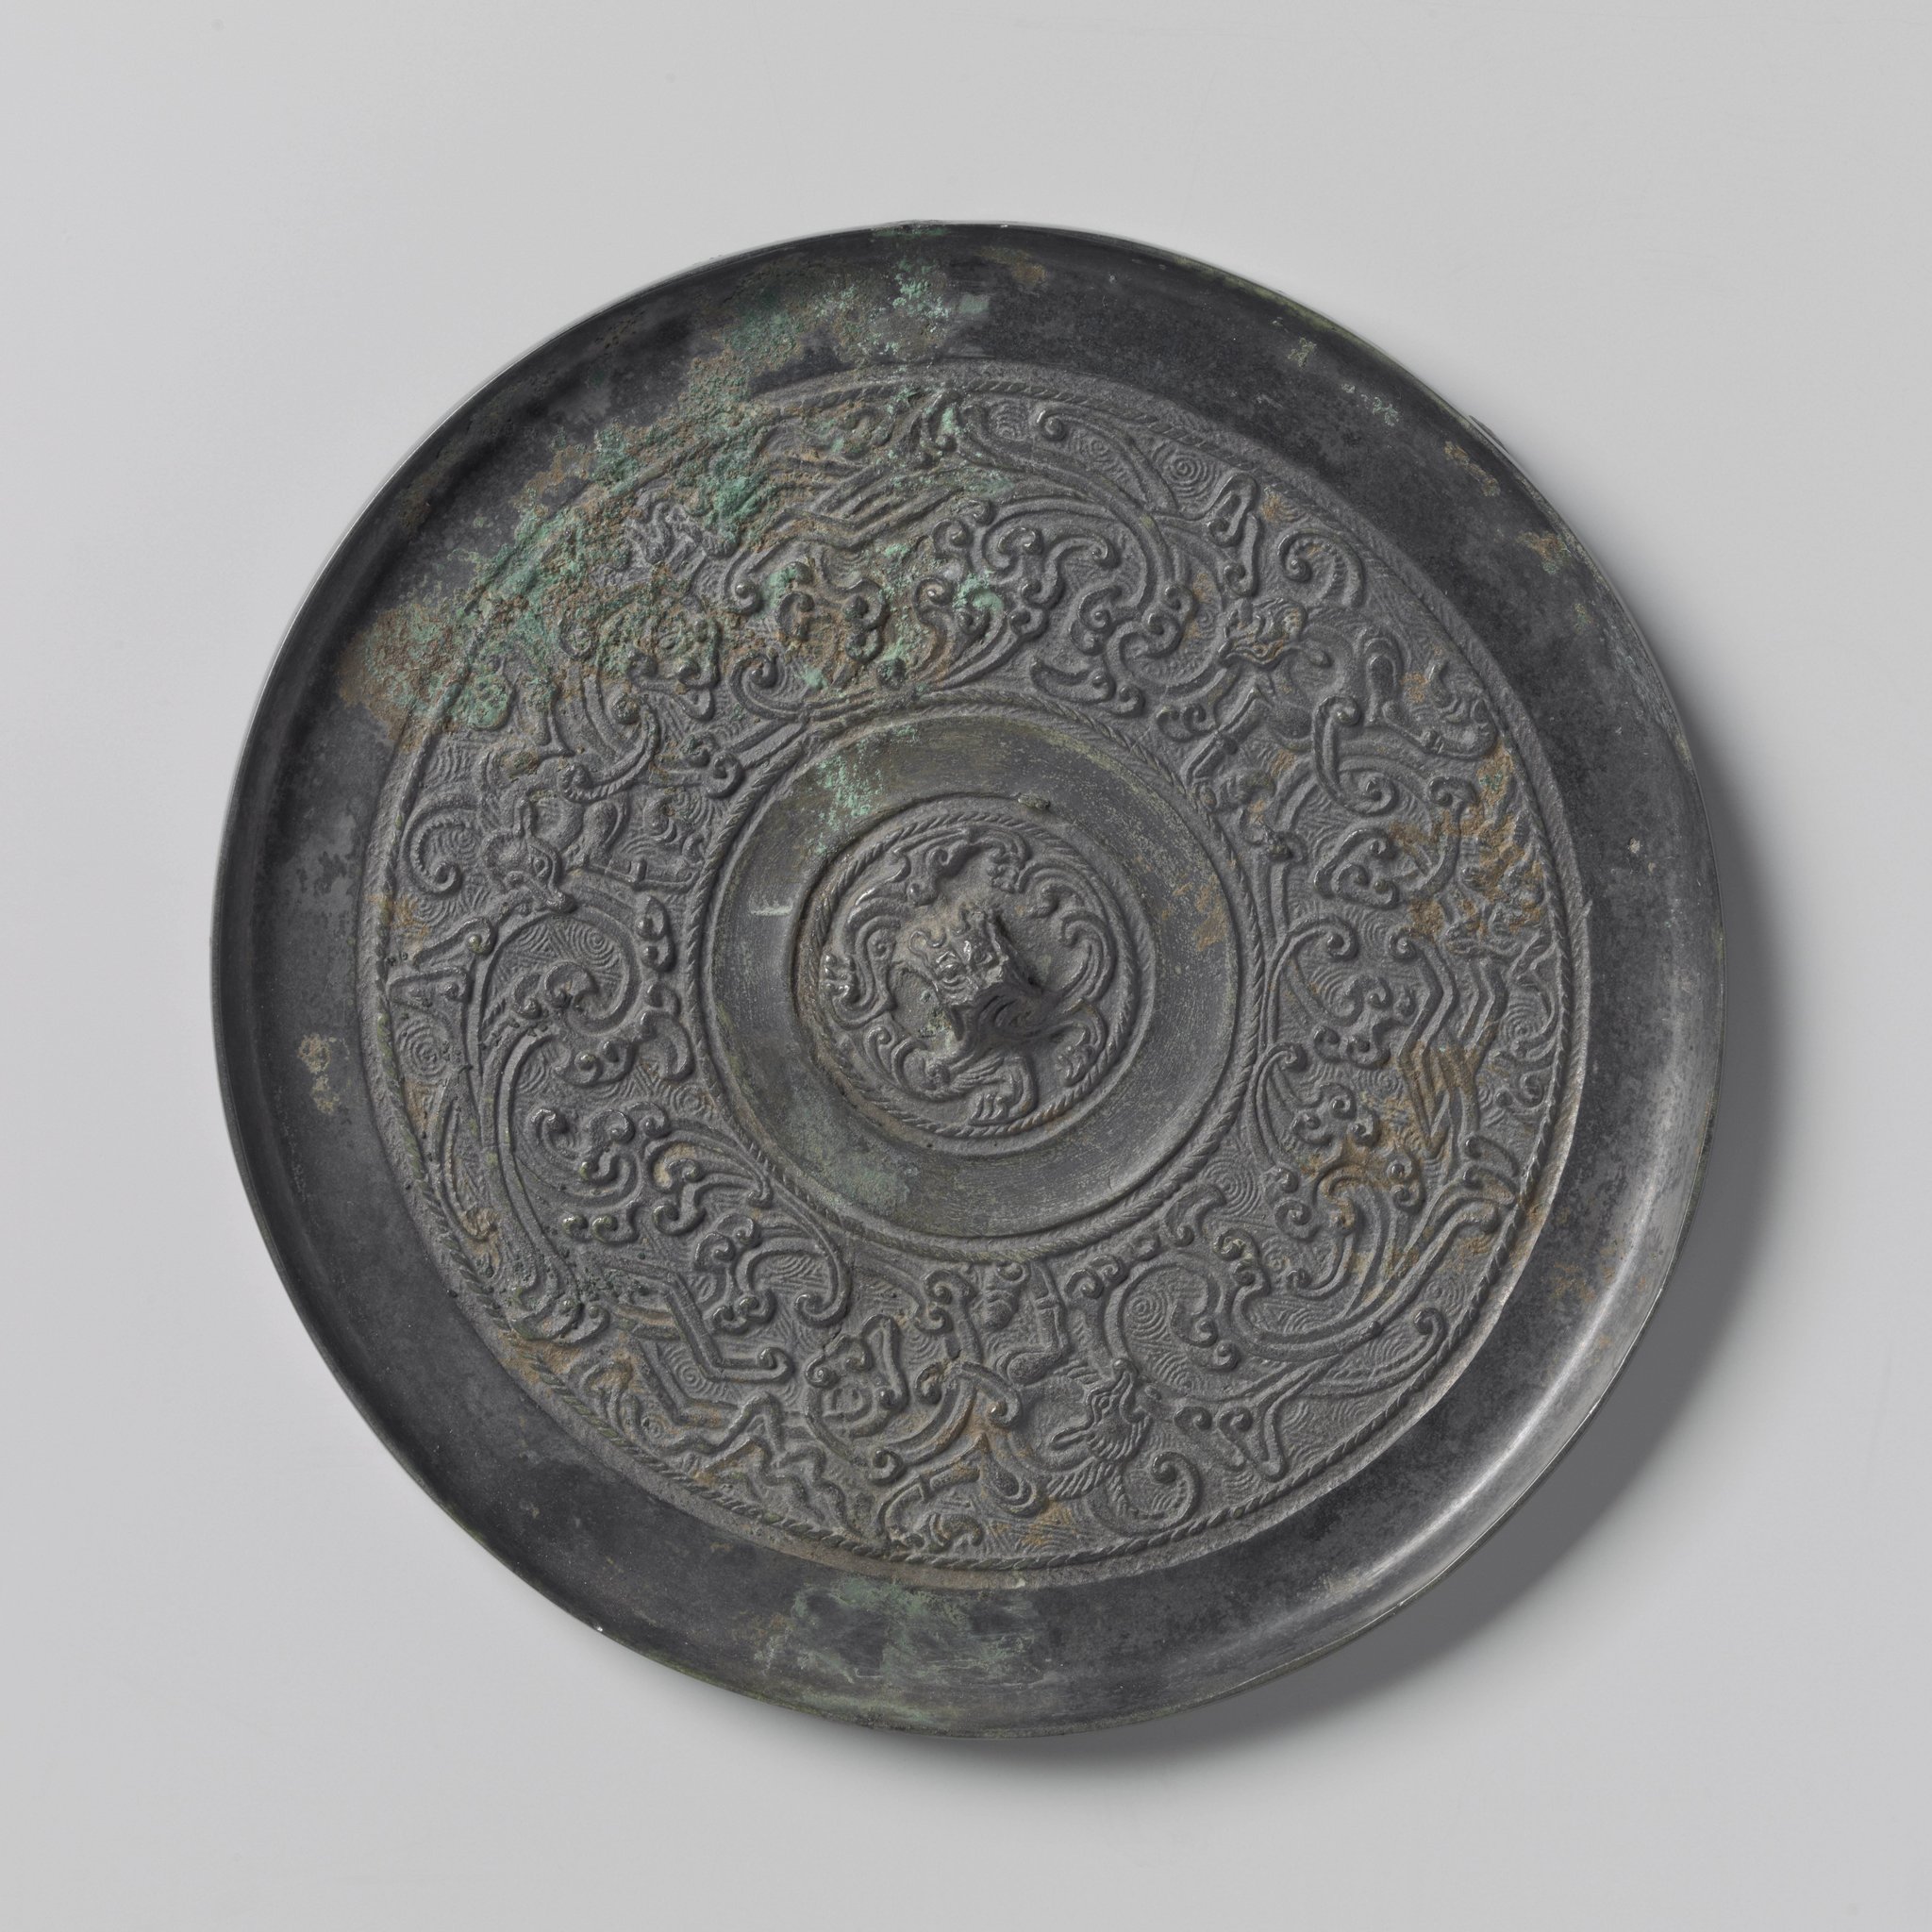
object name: mirror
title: Mirror with a monster's head eye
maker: Anonymous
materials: bronze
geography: china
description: Mirror with a monster's head eye and decorated with entwined arabesques and animal figures. Western Han period (206 BC - AD 9).